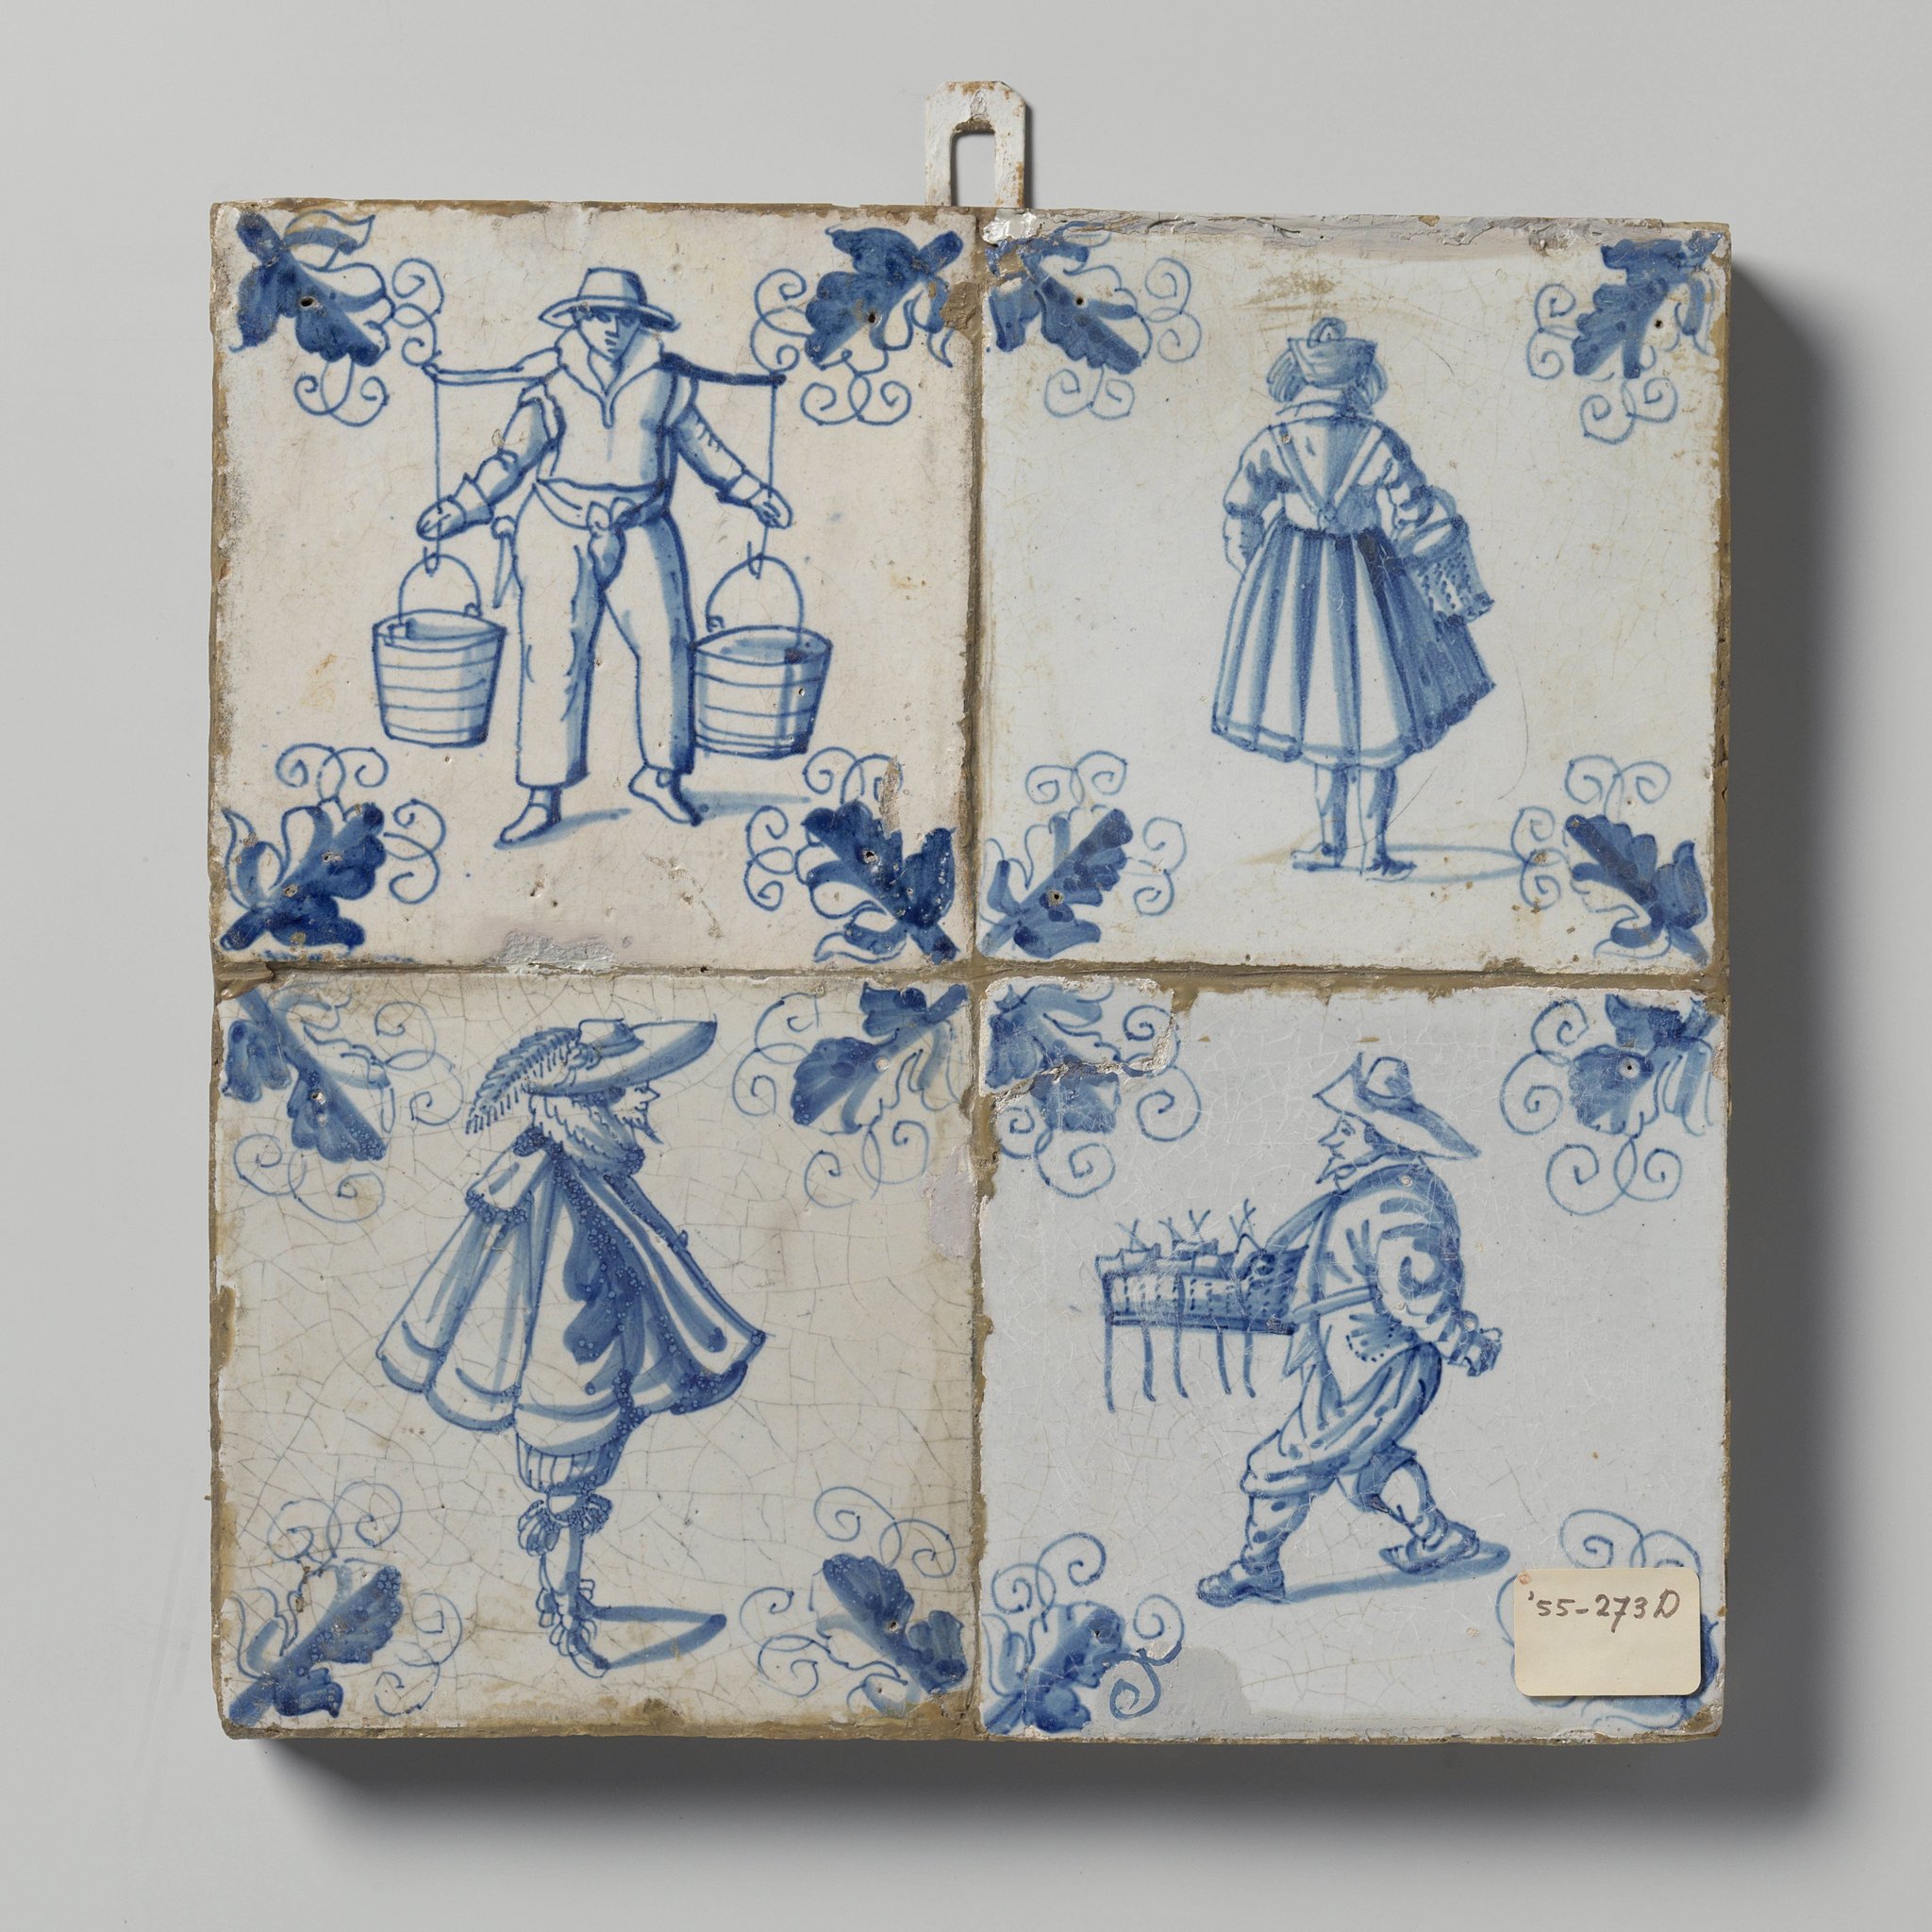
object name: tile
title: Veld van vier tegels met mensen en hun bezigheden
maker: Anonymous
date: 1620-1650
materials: earthenware, glaze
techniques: maiolica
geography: netherlands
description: Veld van vier tegels (2 x 2) elk met een blauw geschilderd mens en zijn bezigheden met in de hoeken, een wingerd.